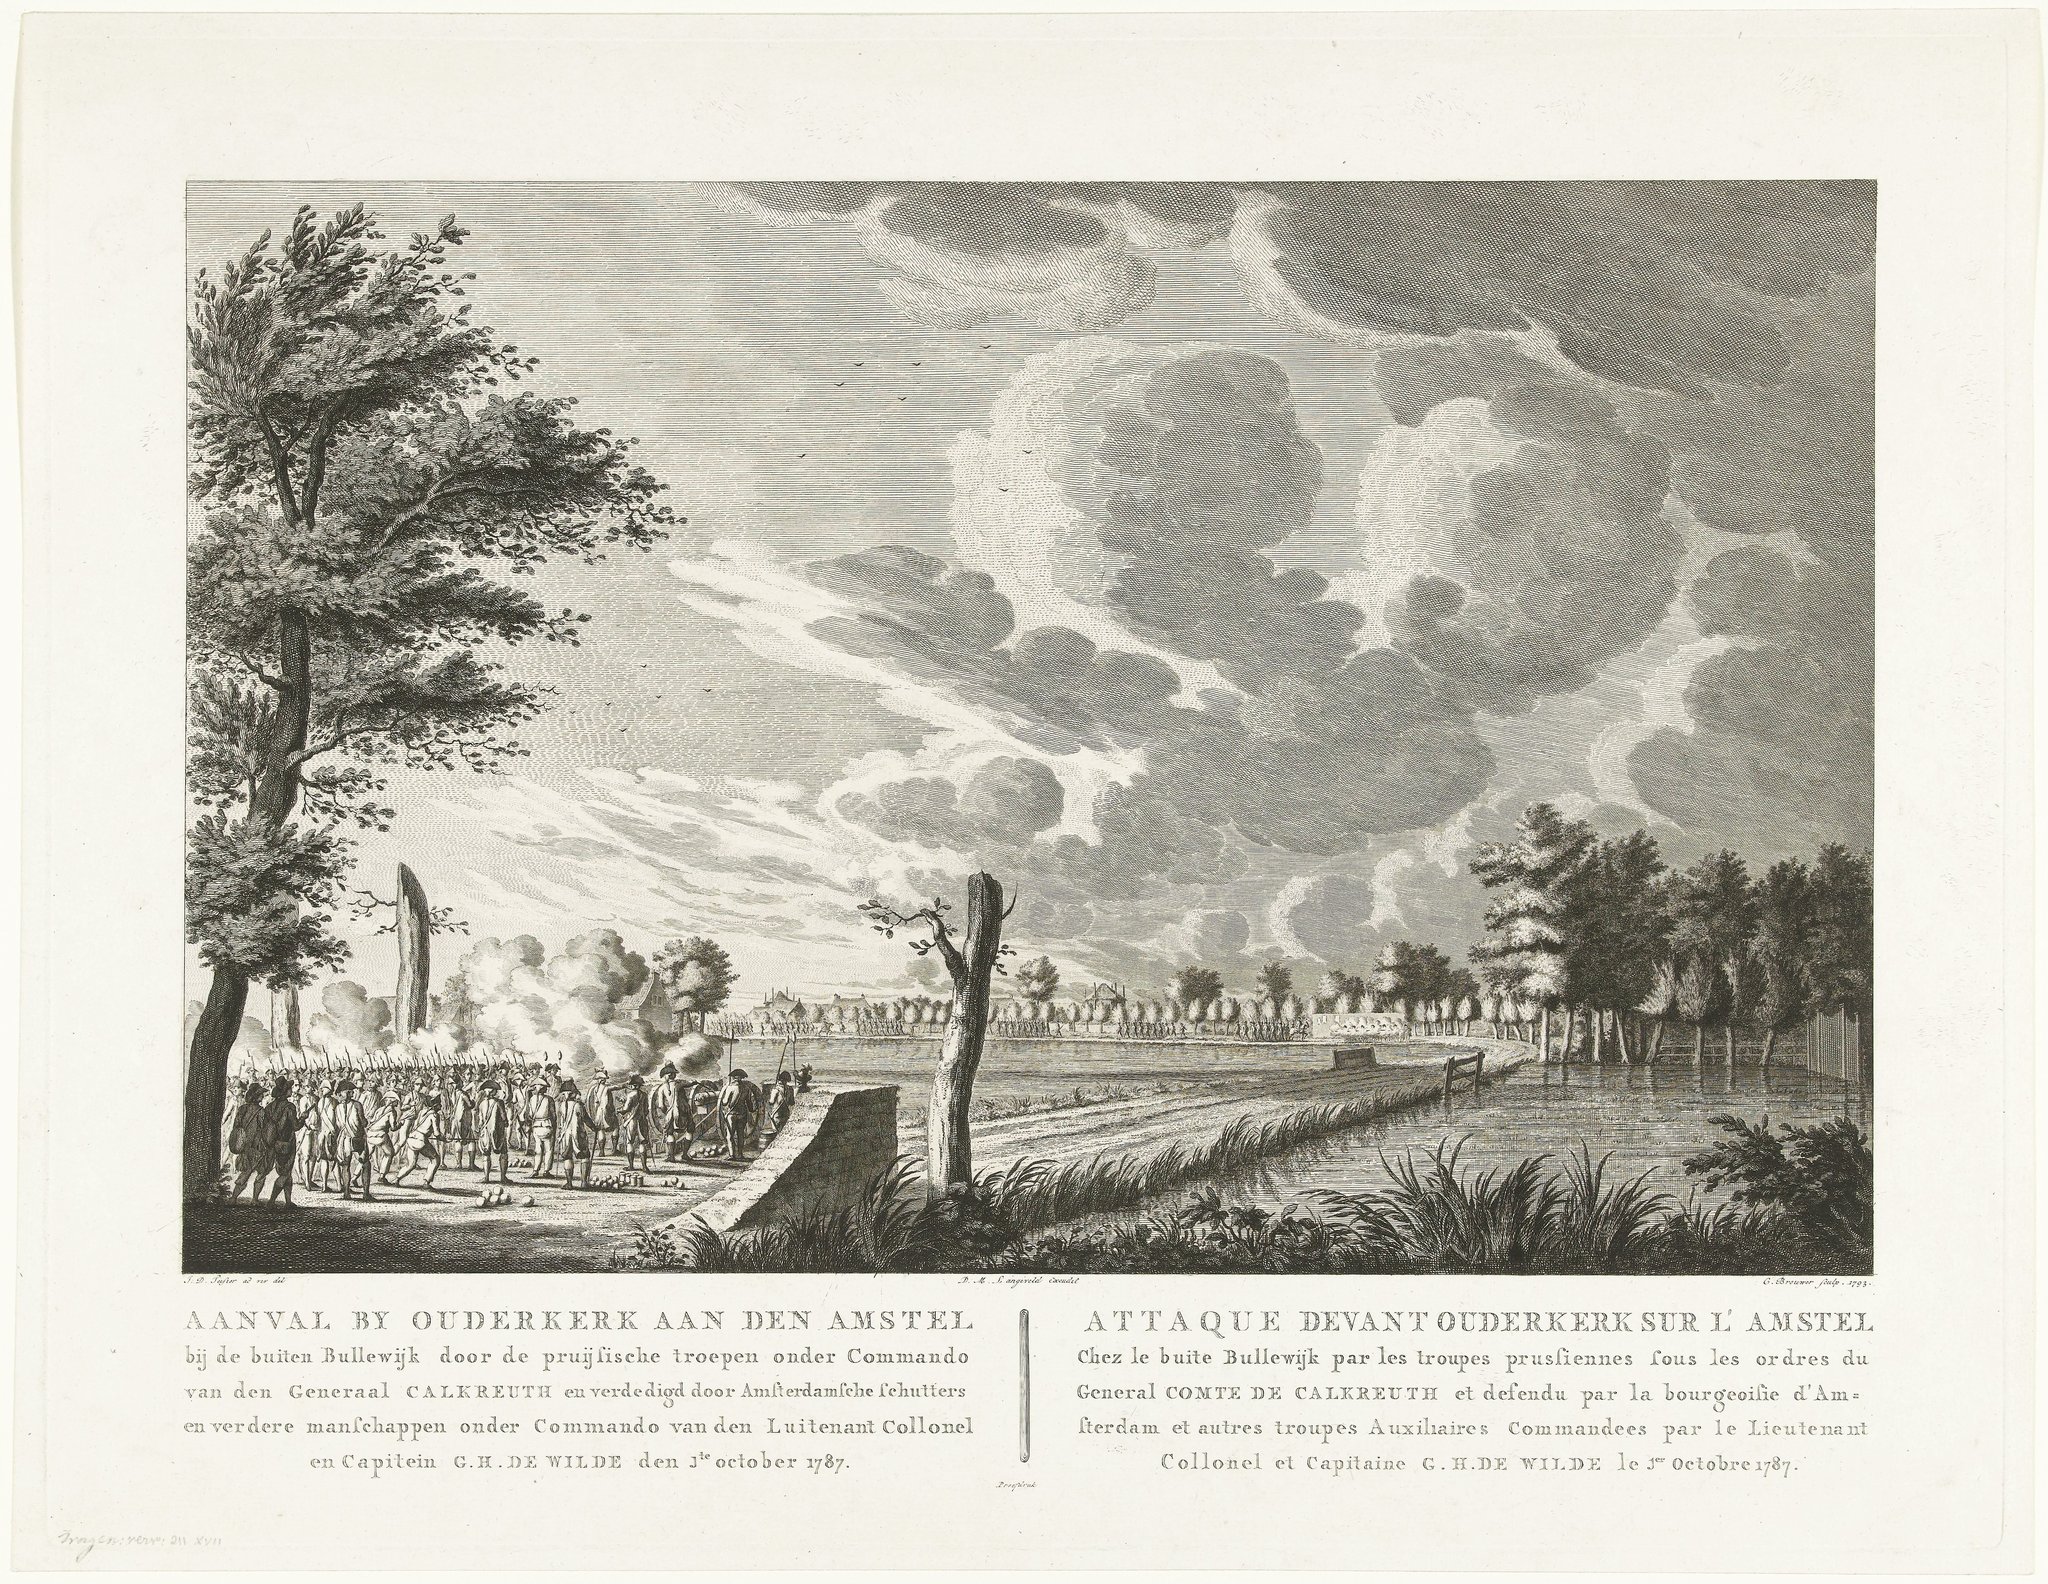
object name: print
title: Aanval by Ouderkerk aan den Amstel bij de buiten Bullewijk door de pruijsische troepen onder Commando van den Generaal Calkreuth en verdedigd door Amsterdamsche schutters (...) 1ste october 1787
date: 1793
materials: paper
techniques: engraving, etching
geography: amsterdam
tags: attack ~ siege, patriots (1780-1795)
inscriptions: date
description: In het kader van de belegering van Amsterdam, vecht het Pruisische leger onder leiding van generaal Calkreuth op 1 oktober 1787 in de omgeving van Ouderkerk aan de Amstel. De patriotten verdedigen zich en vuren vanuit een stelling kanonnen af op het vijandelijke leger. Onderdeel van een groep van zeven prenten van de gevechten met de Pruissische troepen rond Amsterdam in 1787.